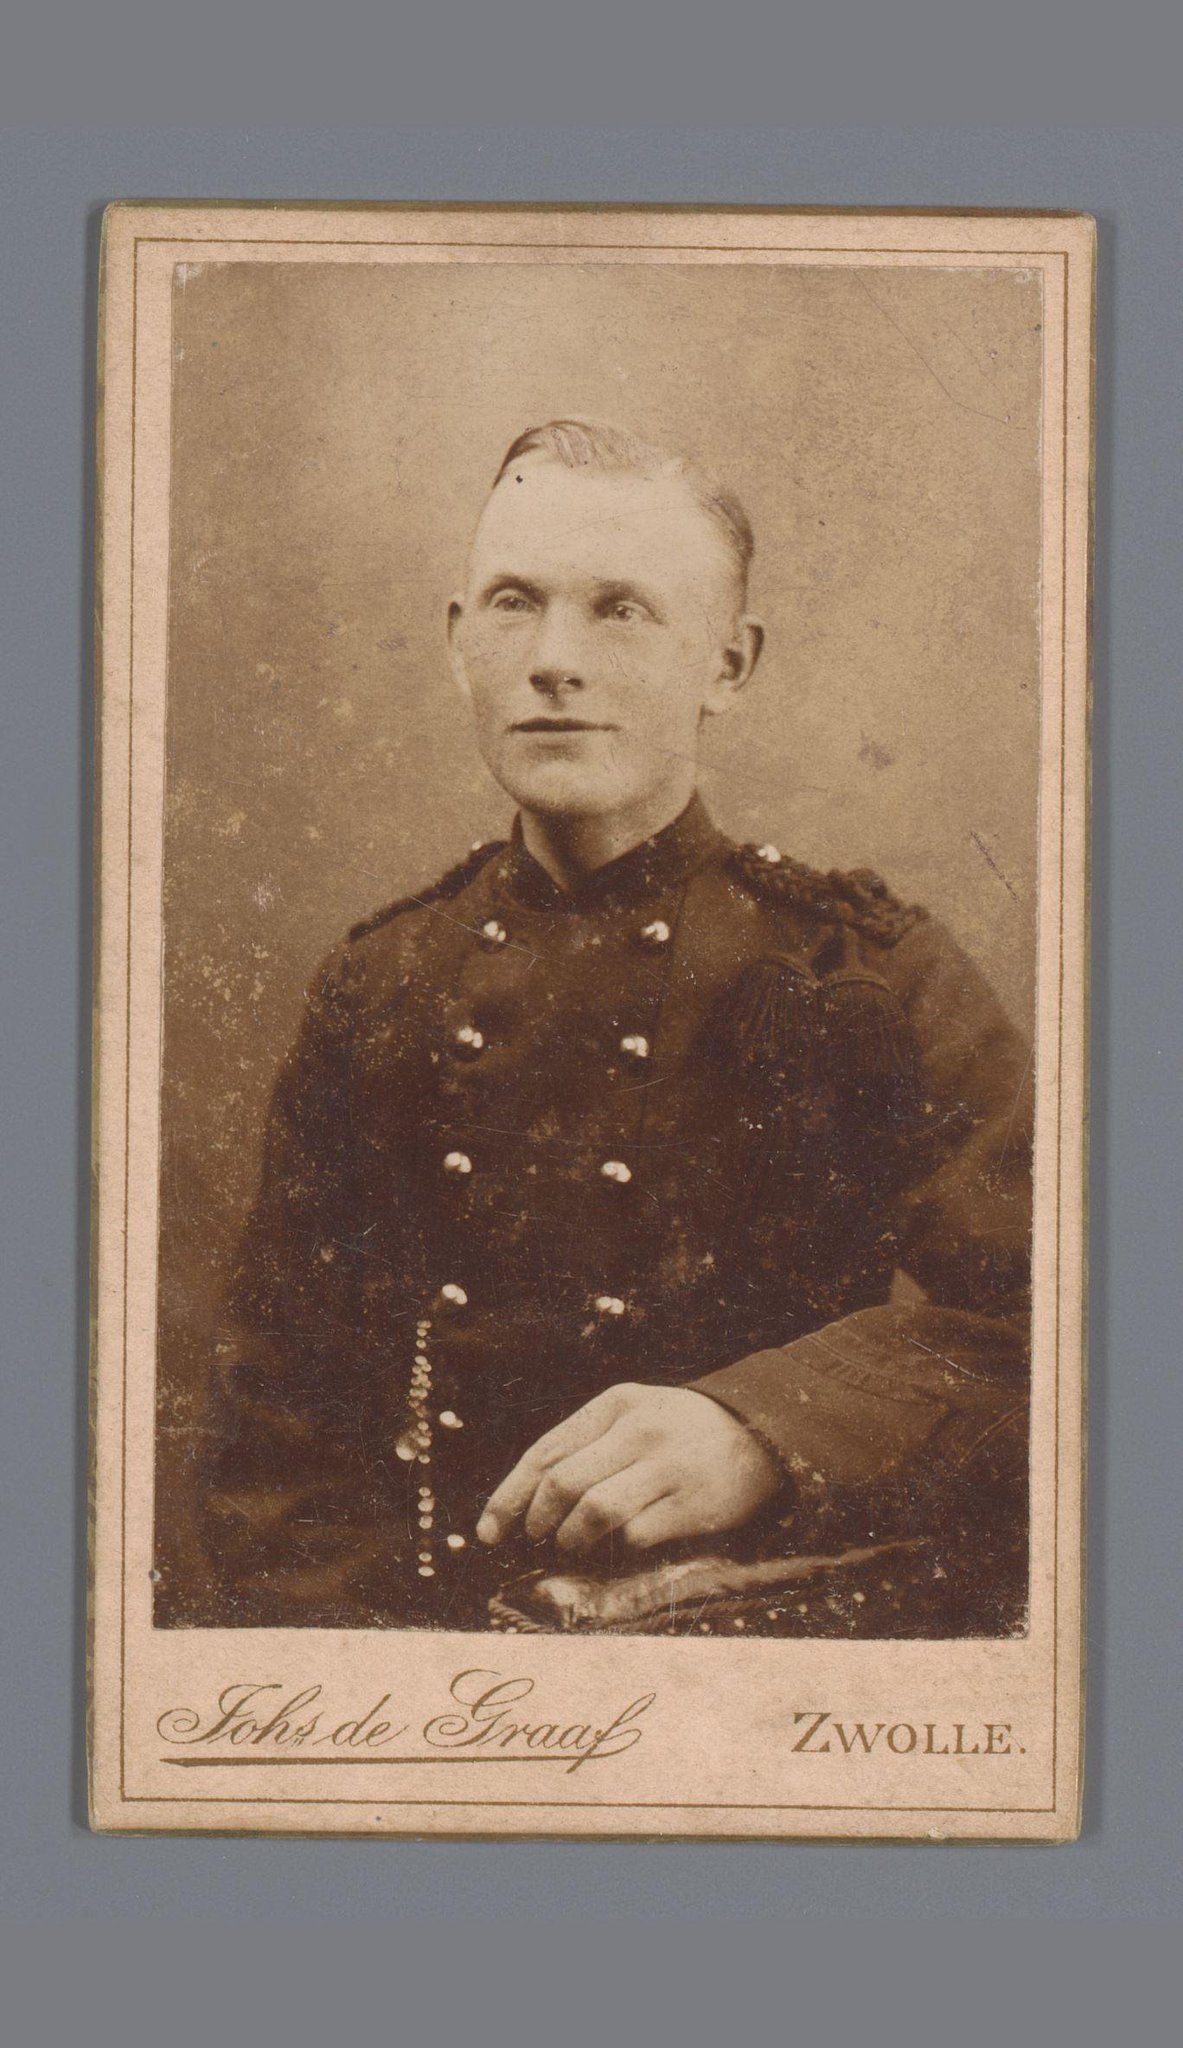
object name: photograph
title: Portret van een onbekende man in uniform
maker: johannes jacobus dirk de graaf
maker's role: fotograaf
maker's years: 1866-1927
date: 1888-1927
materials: cardboard, photographic support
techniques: collodion silver print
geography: zwolle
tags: adult man, historical persons, (military) uniforms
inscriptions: inscription: ‘JC/ Johs de Graaf/ PHOTOGRAFISCHE INRICHTING/ ZWOLLE/ Stationsplein b/h. Station/ Vergrootingen naar alle bestaande portretten./ De platen blijven voor nabestelling bewaard.’